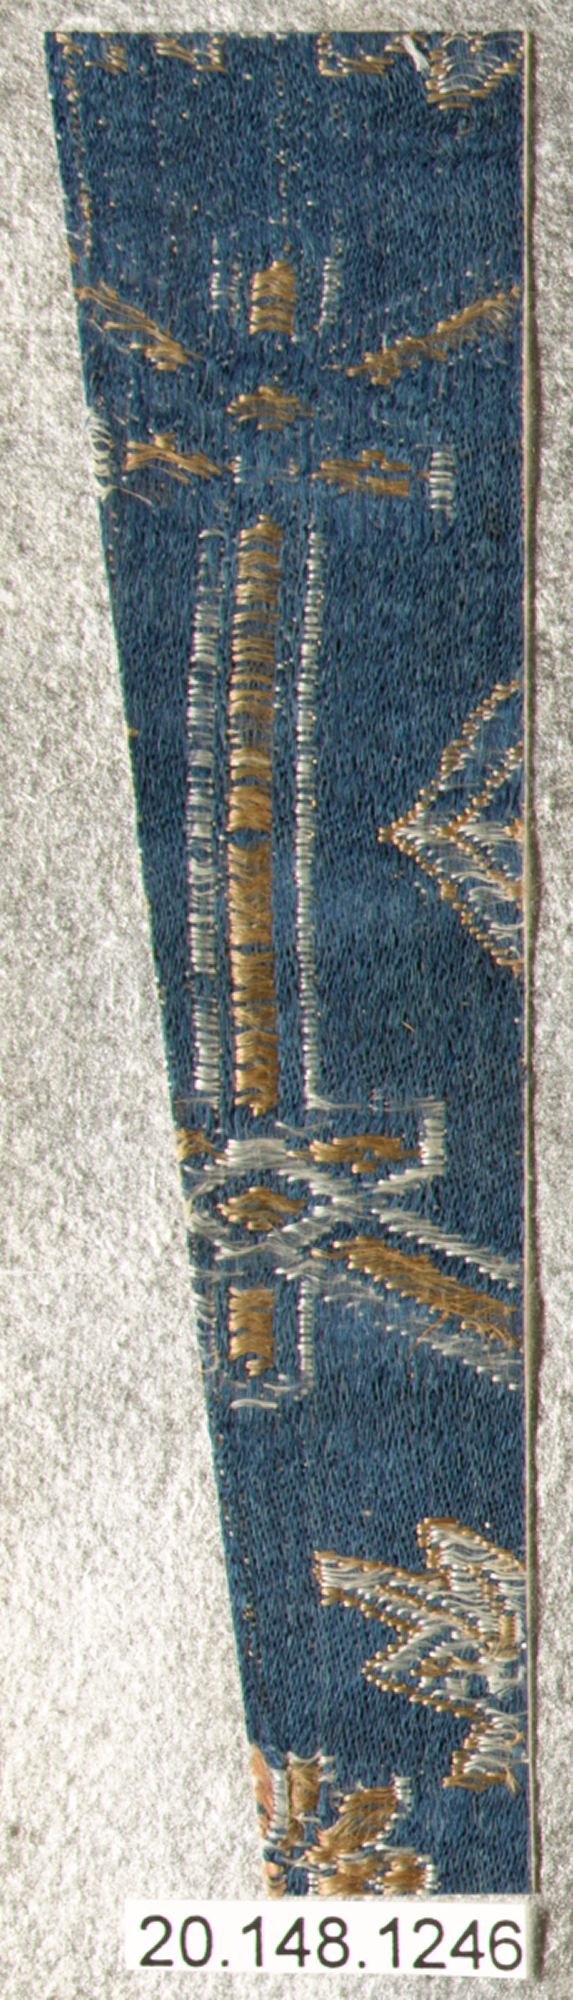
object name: piece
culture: japanese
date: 1801-1900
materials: silk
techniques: compound weave